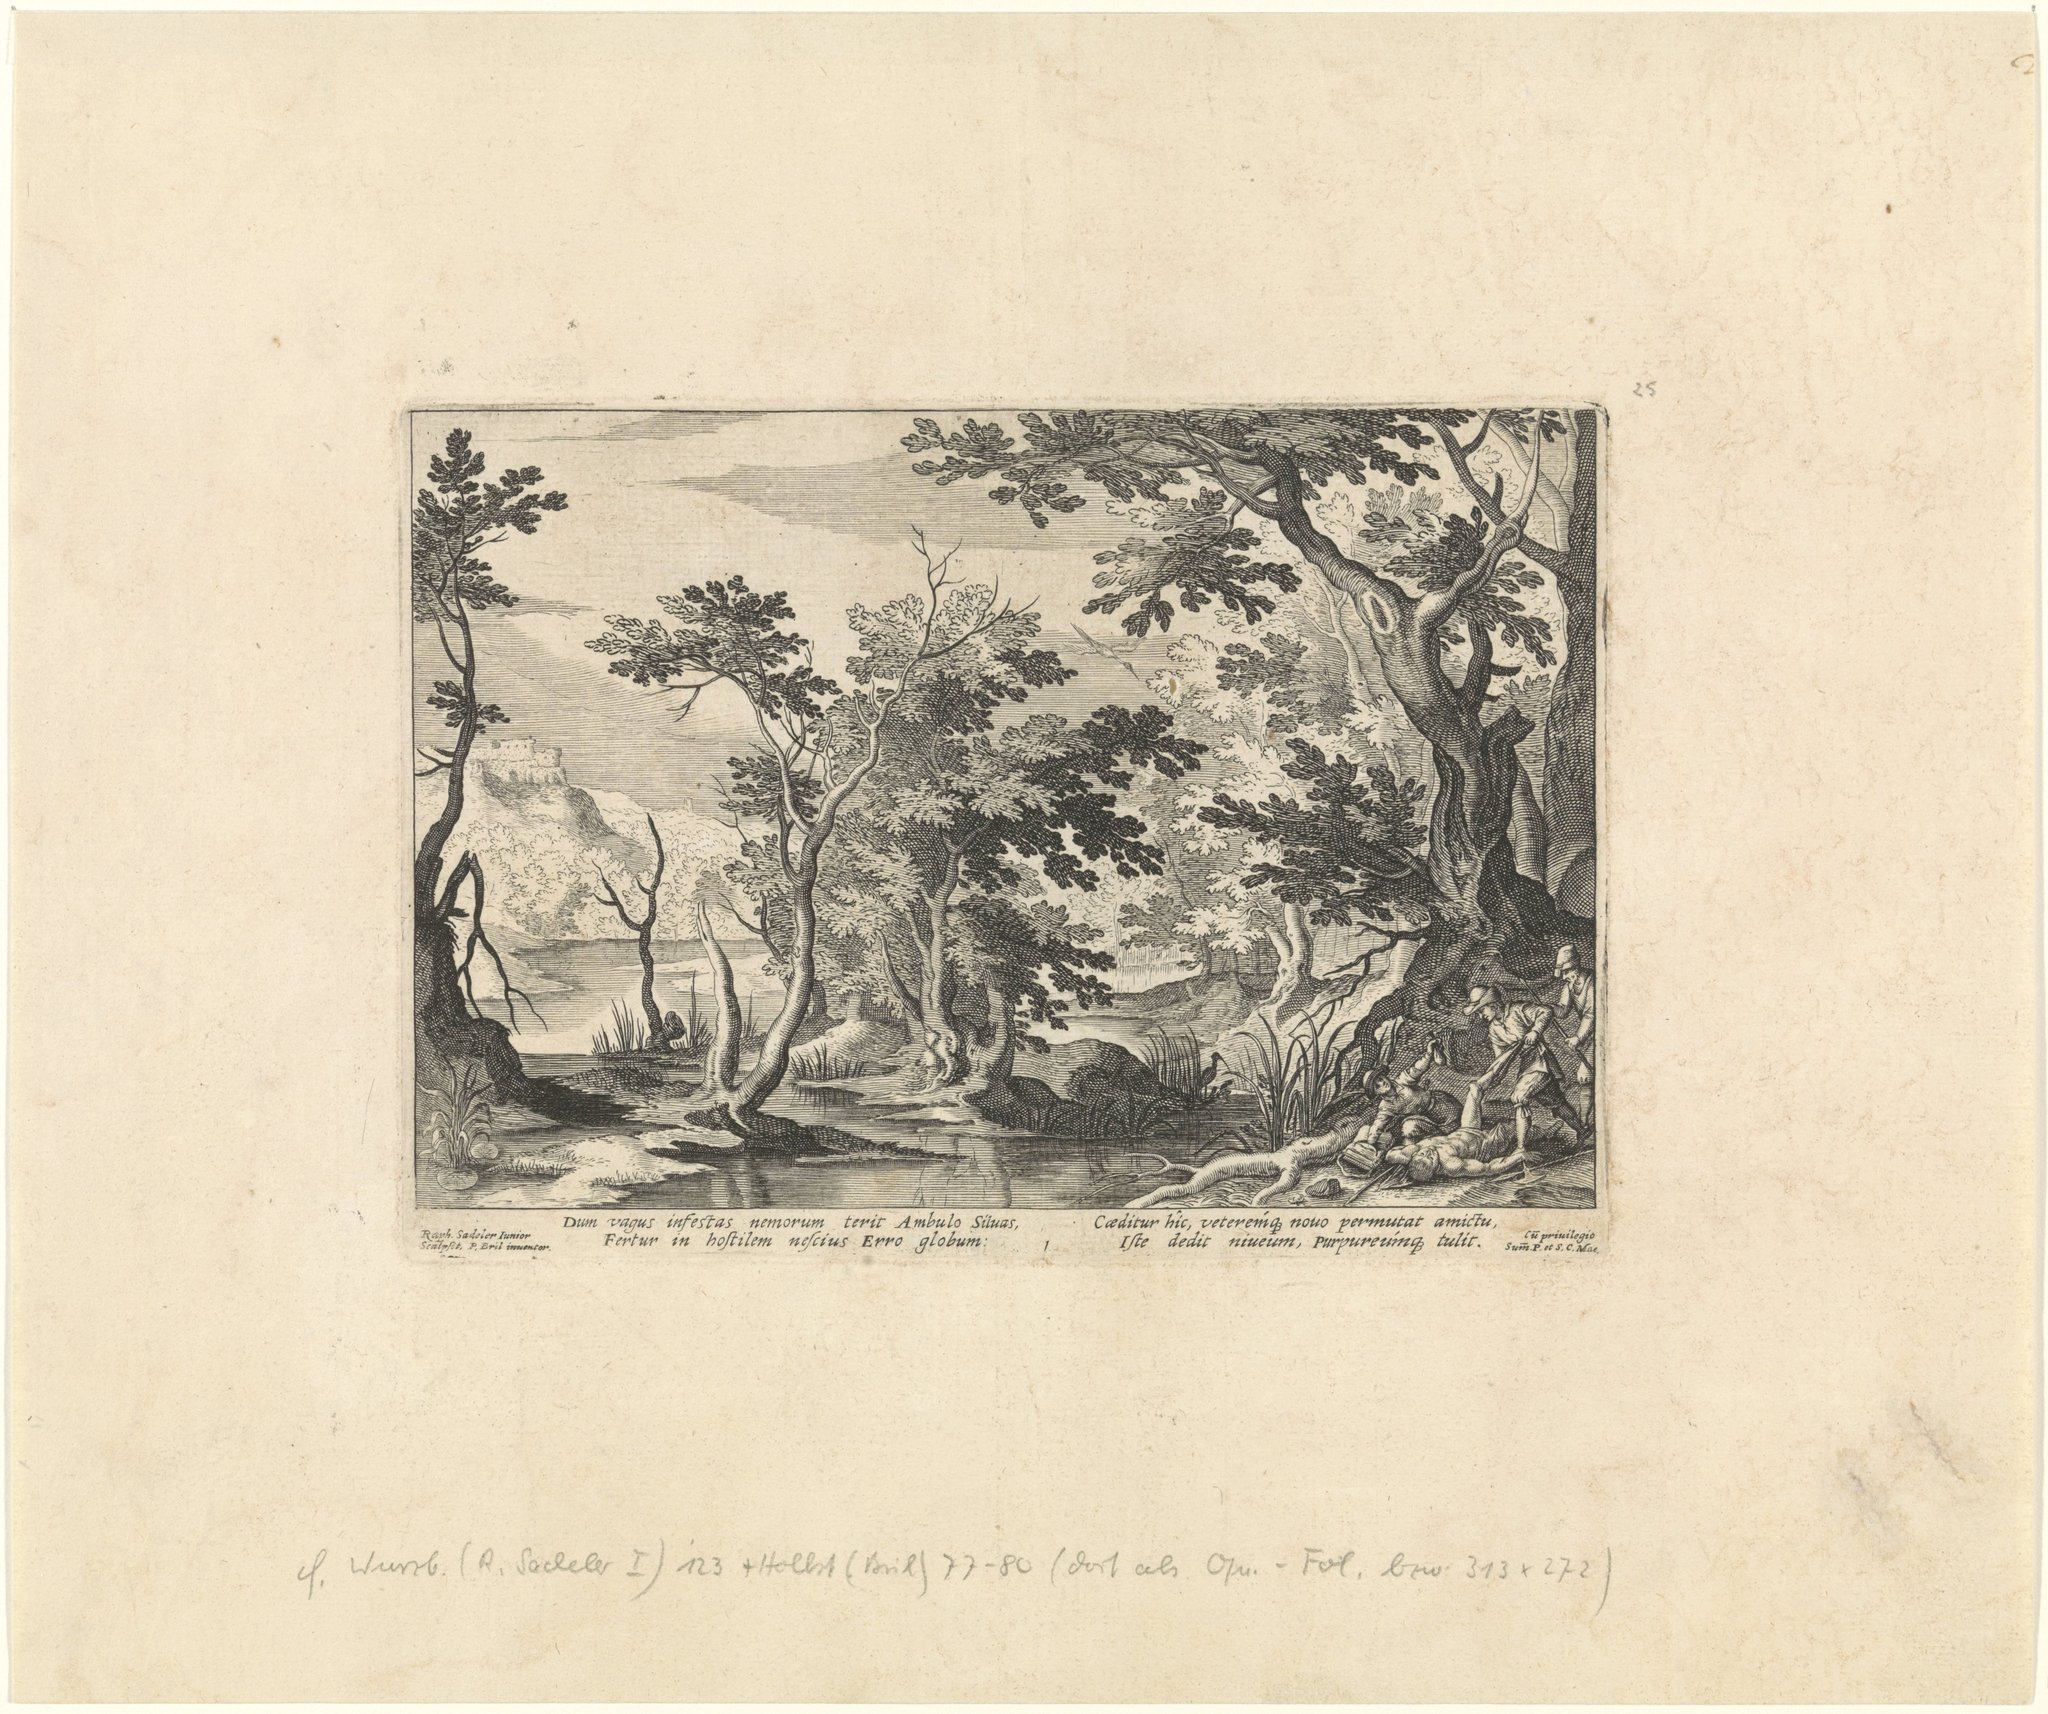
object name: print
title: Landschap met de beroving van de barmhartige Samaritaan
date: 1594-1632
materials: paper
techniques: engraving, etching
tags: river, the traveller is attacked by robbers ~ parable of the good samaritan, forest, wood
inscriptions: collector's mark: Lugt 2228, collector's mark: Lugt 2760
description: Een boslandschap. In de rechterhoek aan de oever van een rivier wordt een reiziger door struikrovers overvallen en beroofd.